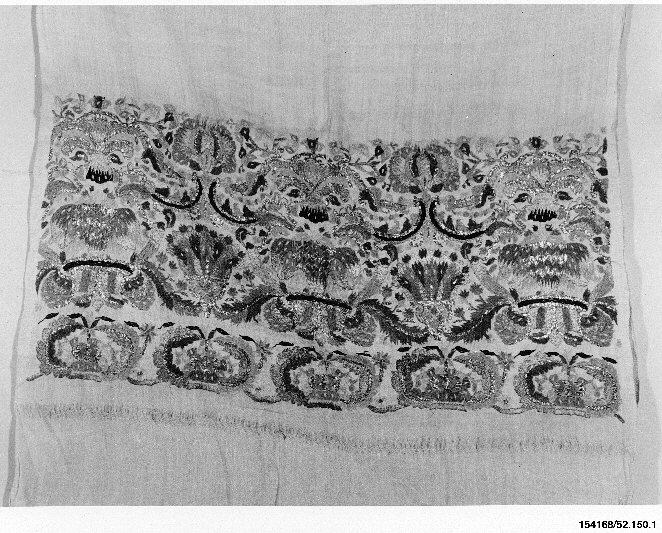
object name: towel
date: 1701-1800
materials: linen, metal thread, silk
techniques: embroidery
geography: turkey